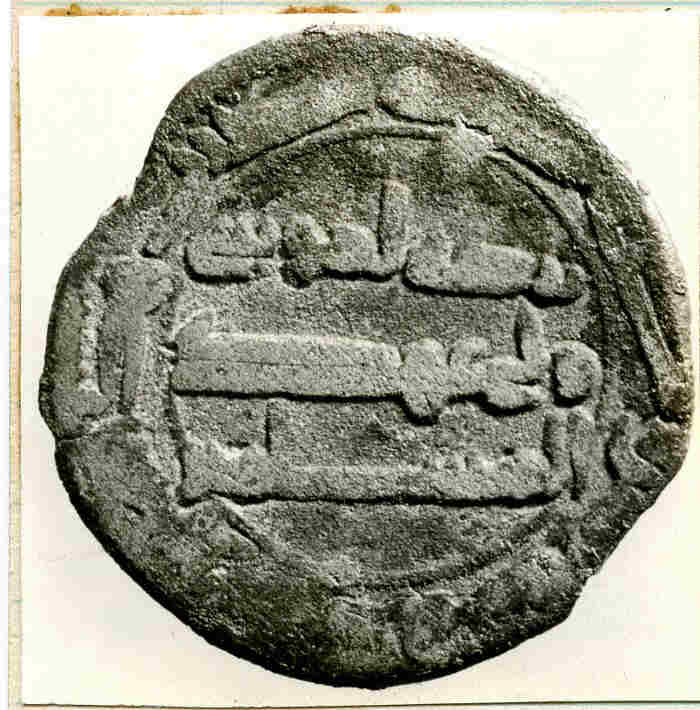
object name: coin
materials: copper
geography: uzbekistan